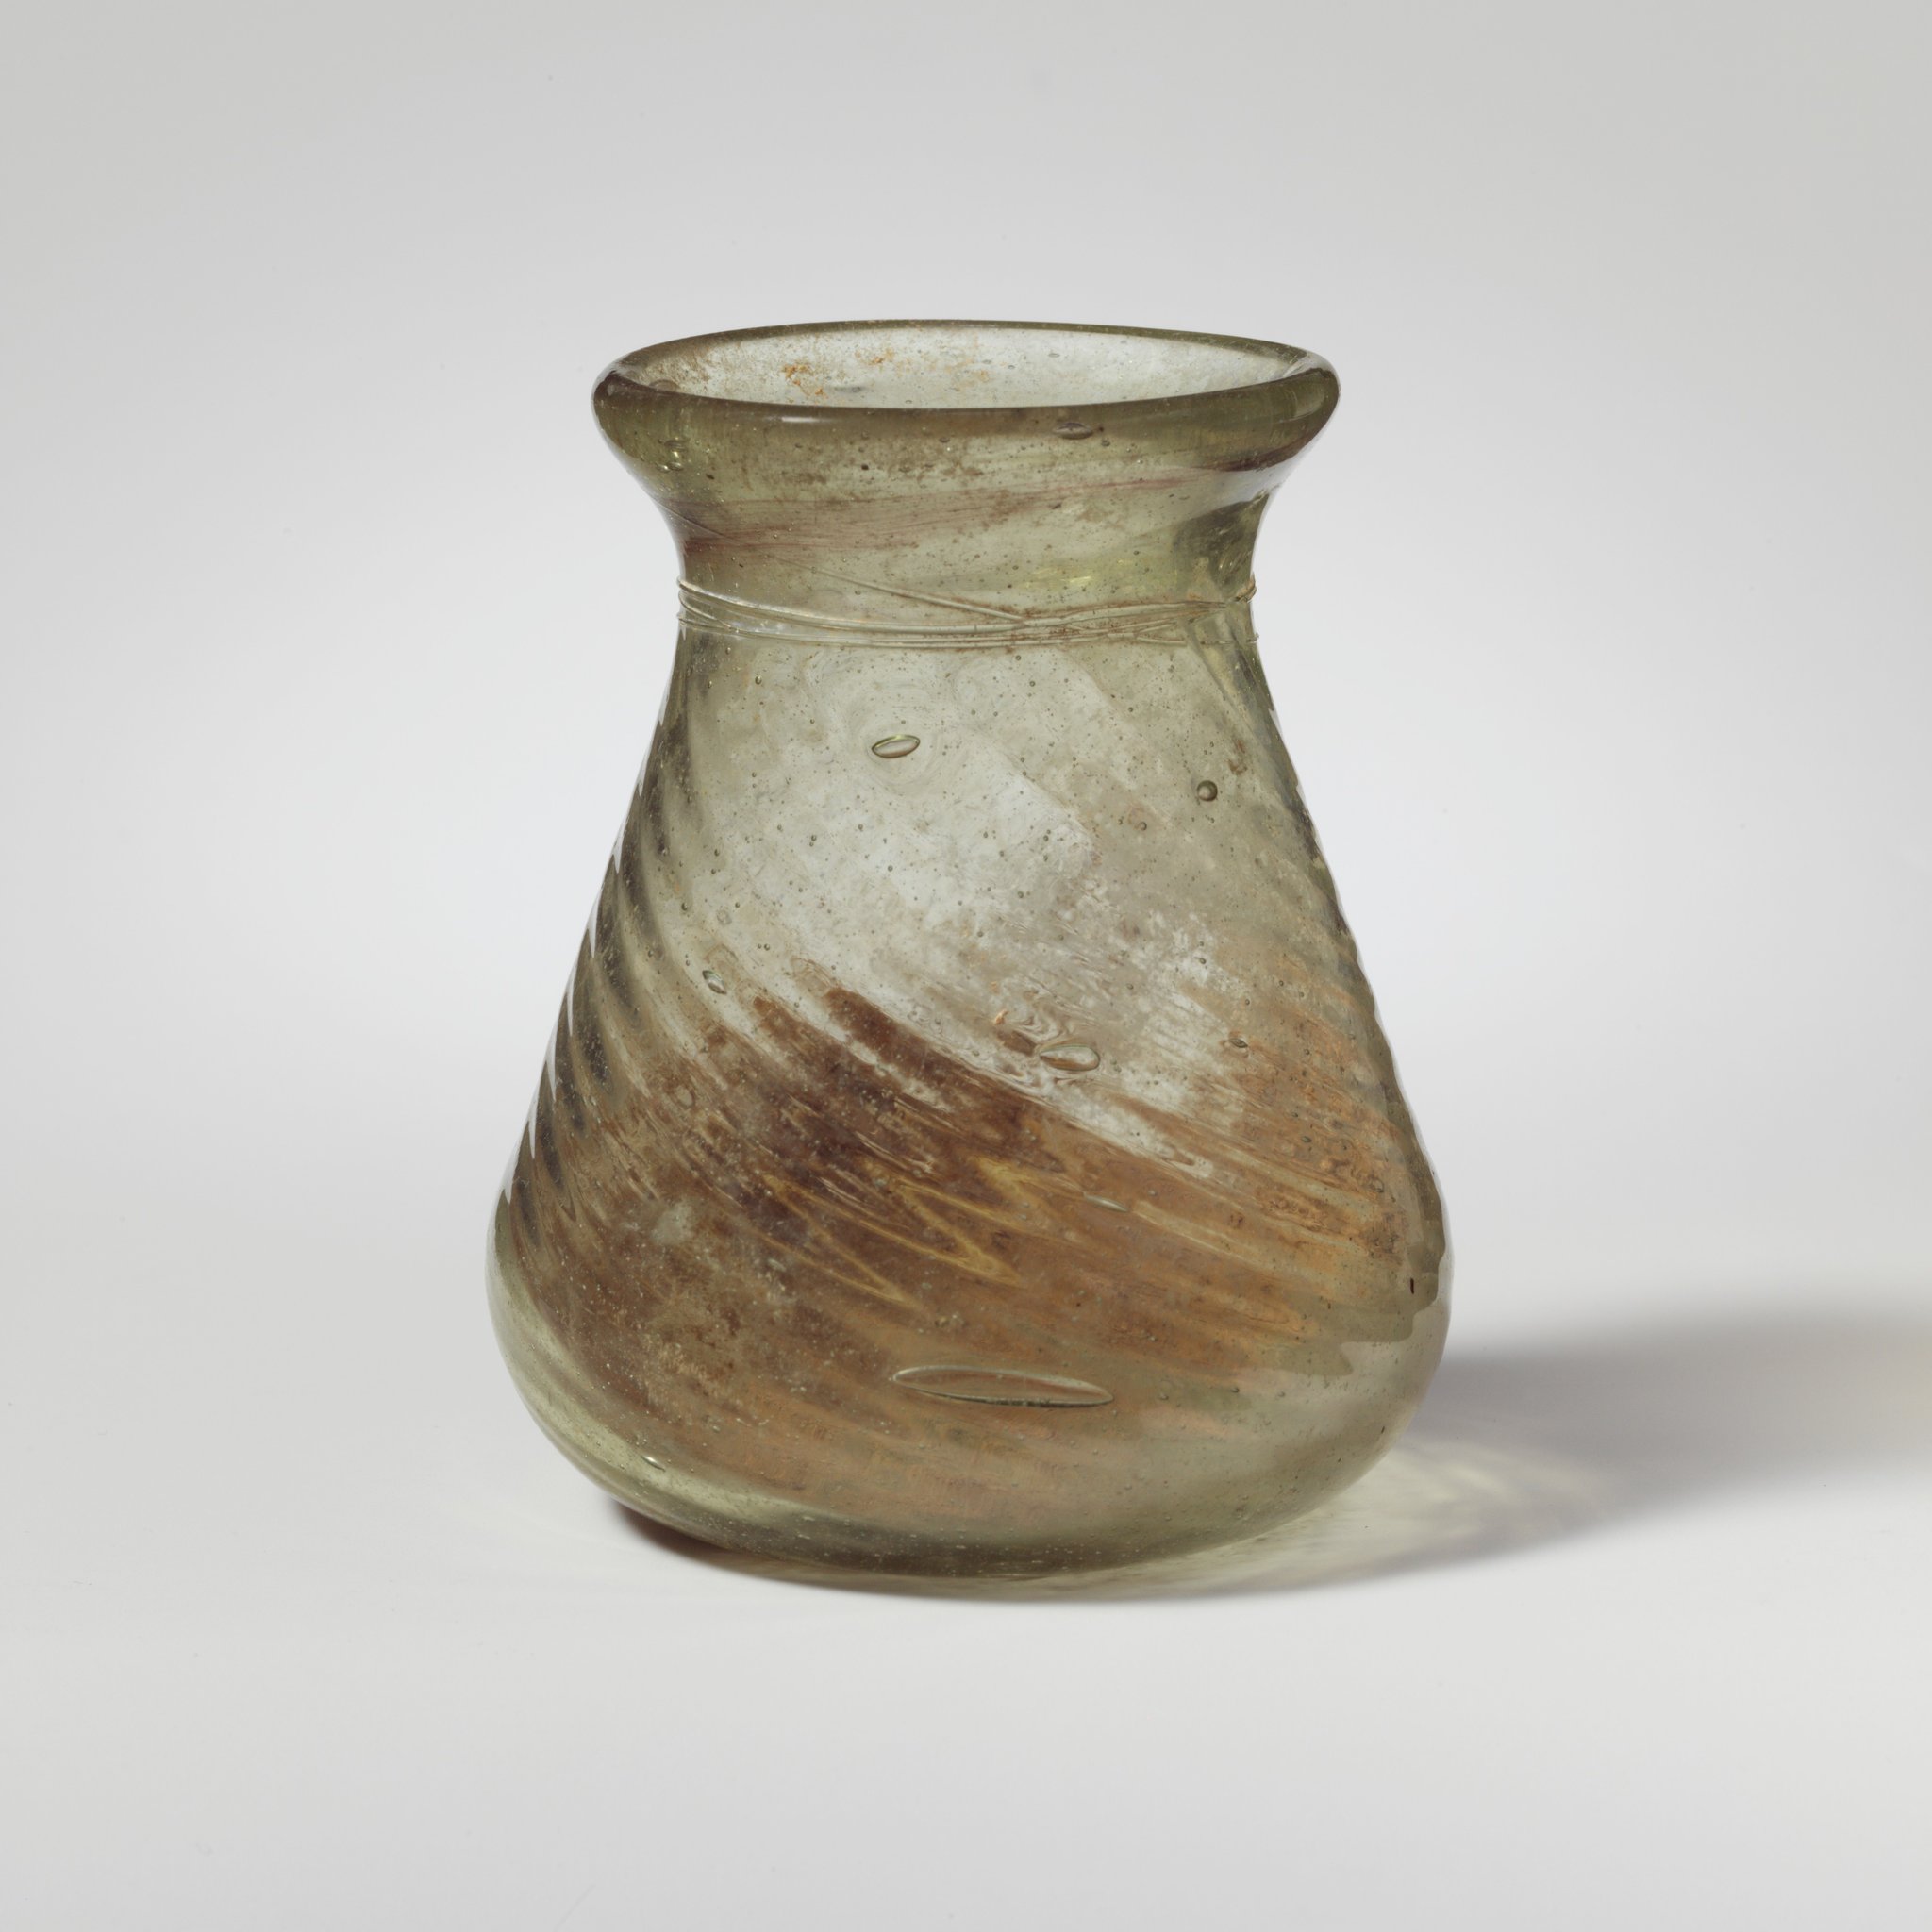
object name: jar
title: Glass jar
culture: roman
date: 267-400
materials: glass